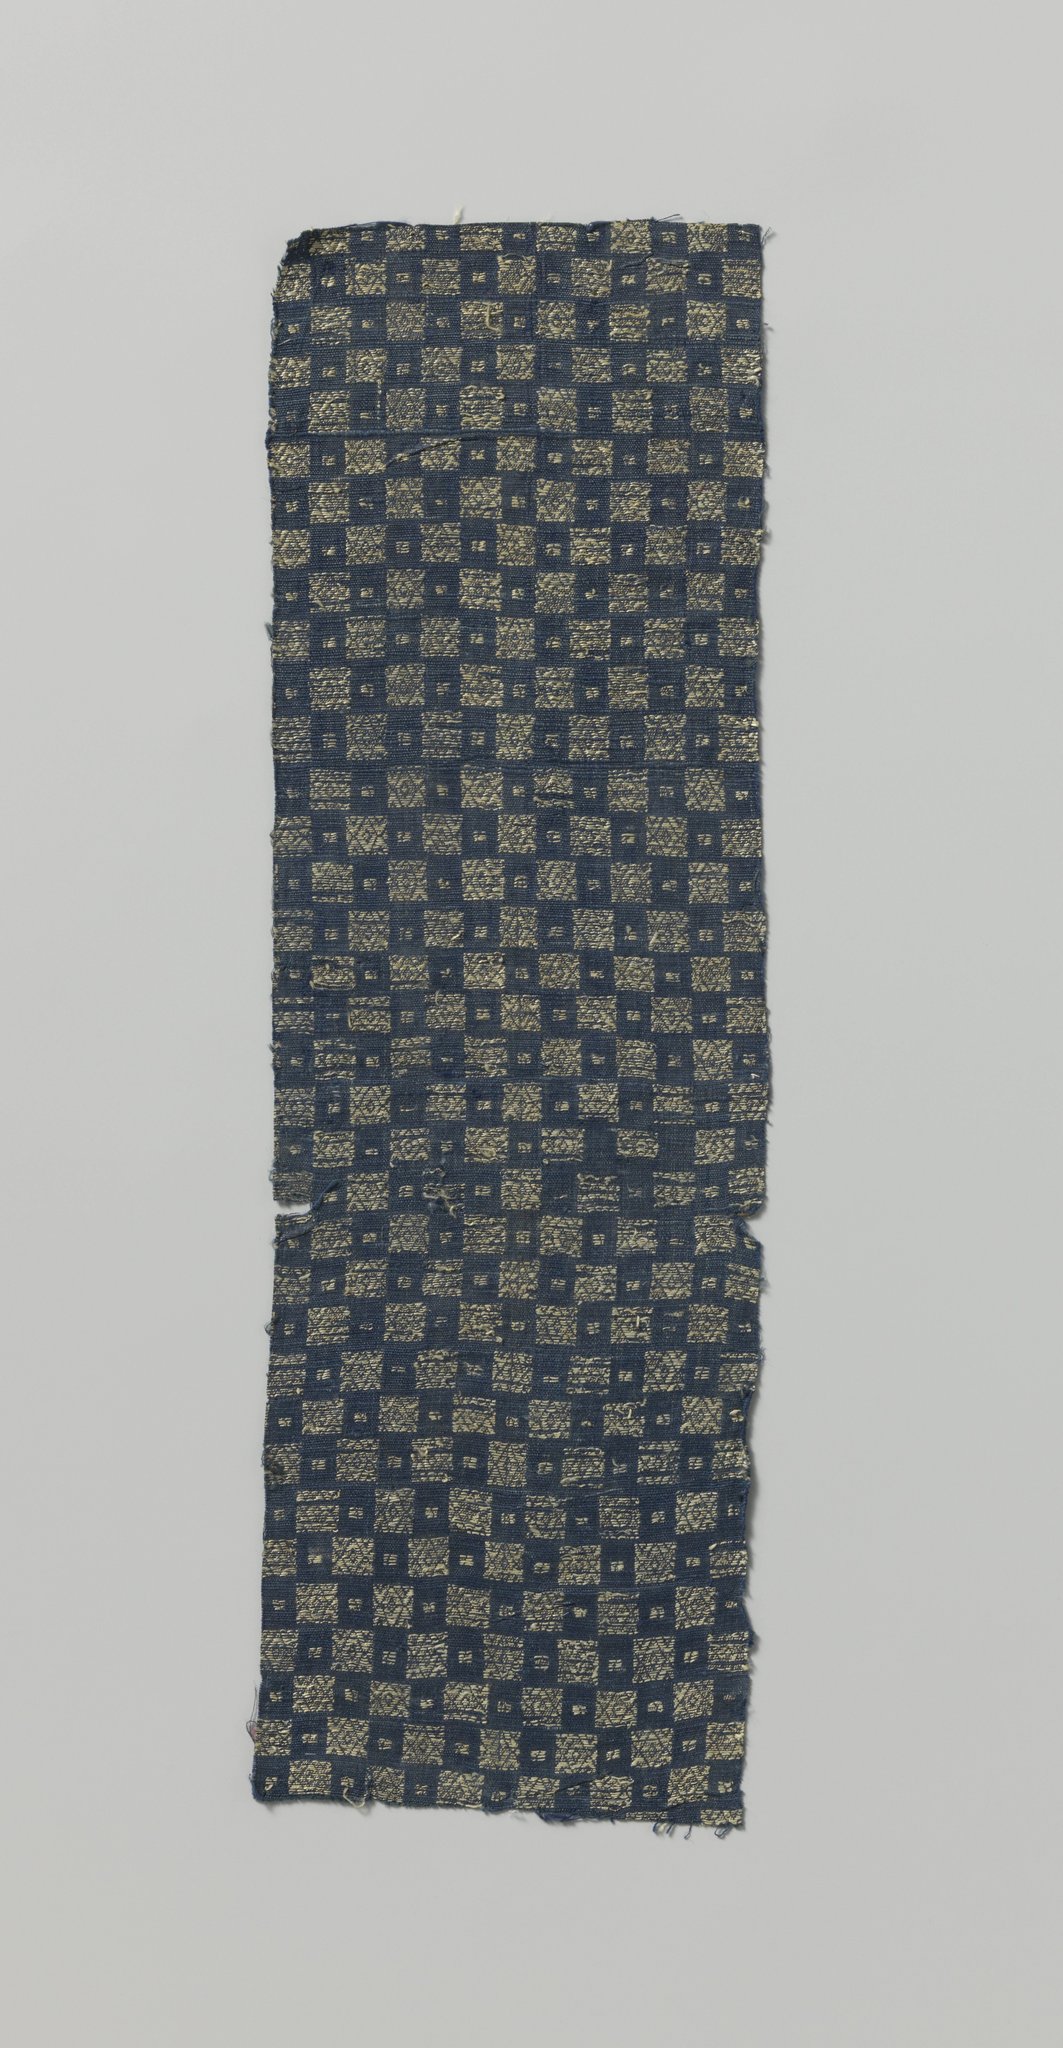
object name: fragment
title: Fragment oosterse textiel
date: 1800-1850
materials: cotton, silk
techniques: brocade, weave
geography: india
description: Een fragment van een weefsel. Vierkanten in wit en goud op een donker blauwe grond.